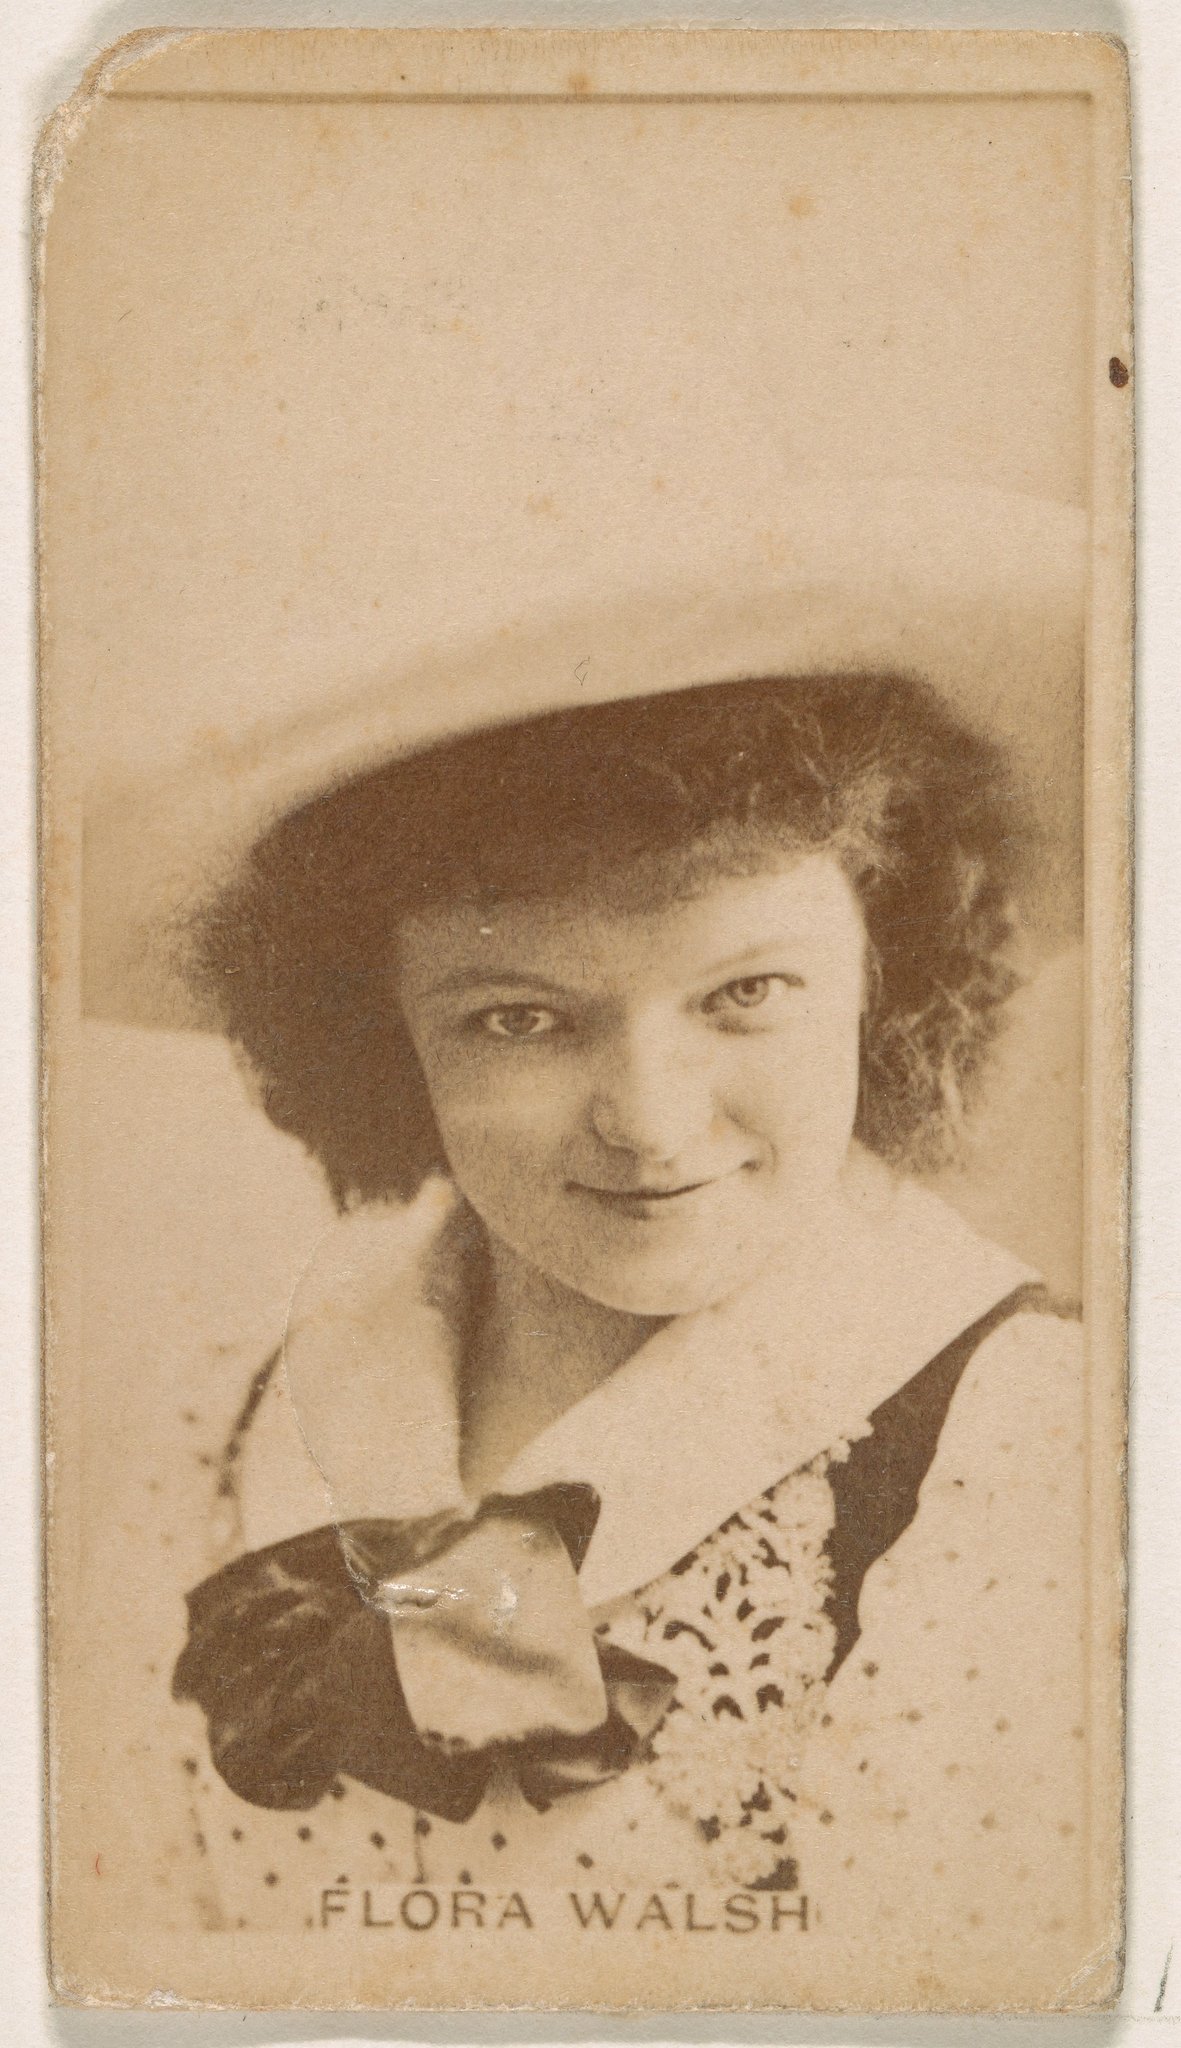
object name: photograph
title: Flora Walsh, from the Actresses series (N245) issued by Kinney Brothers to promote Sweet Caporal Cigarettes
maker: kinney brothers tobacco company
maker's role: publisher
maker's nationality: american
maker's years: 1869-2011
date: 1890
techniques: albumen silver print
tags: portraits,women,actresses